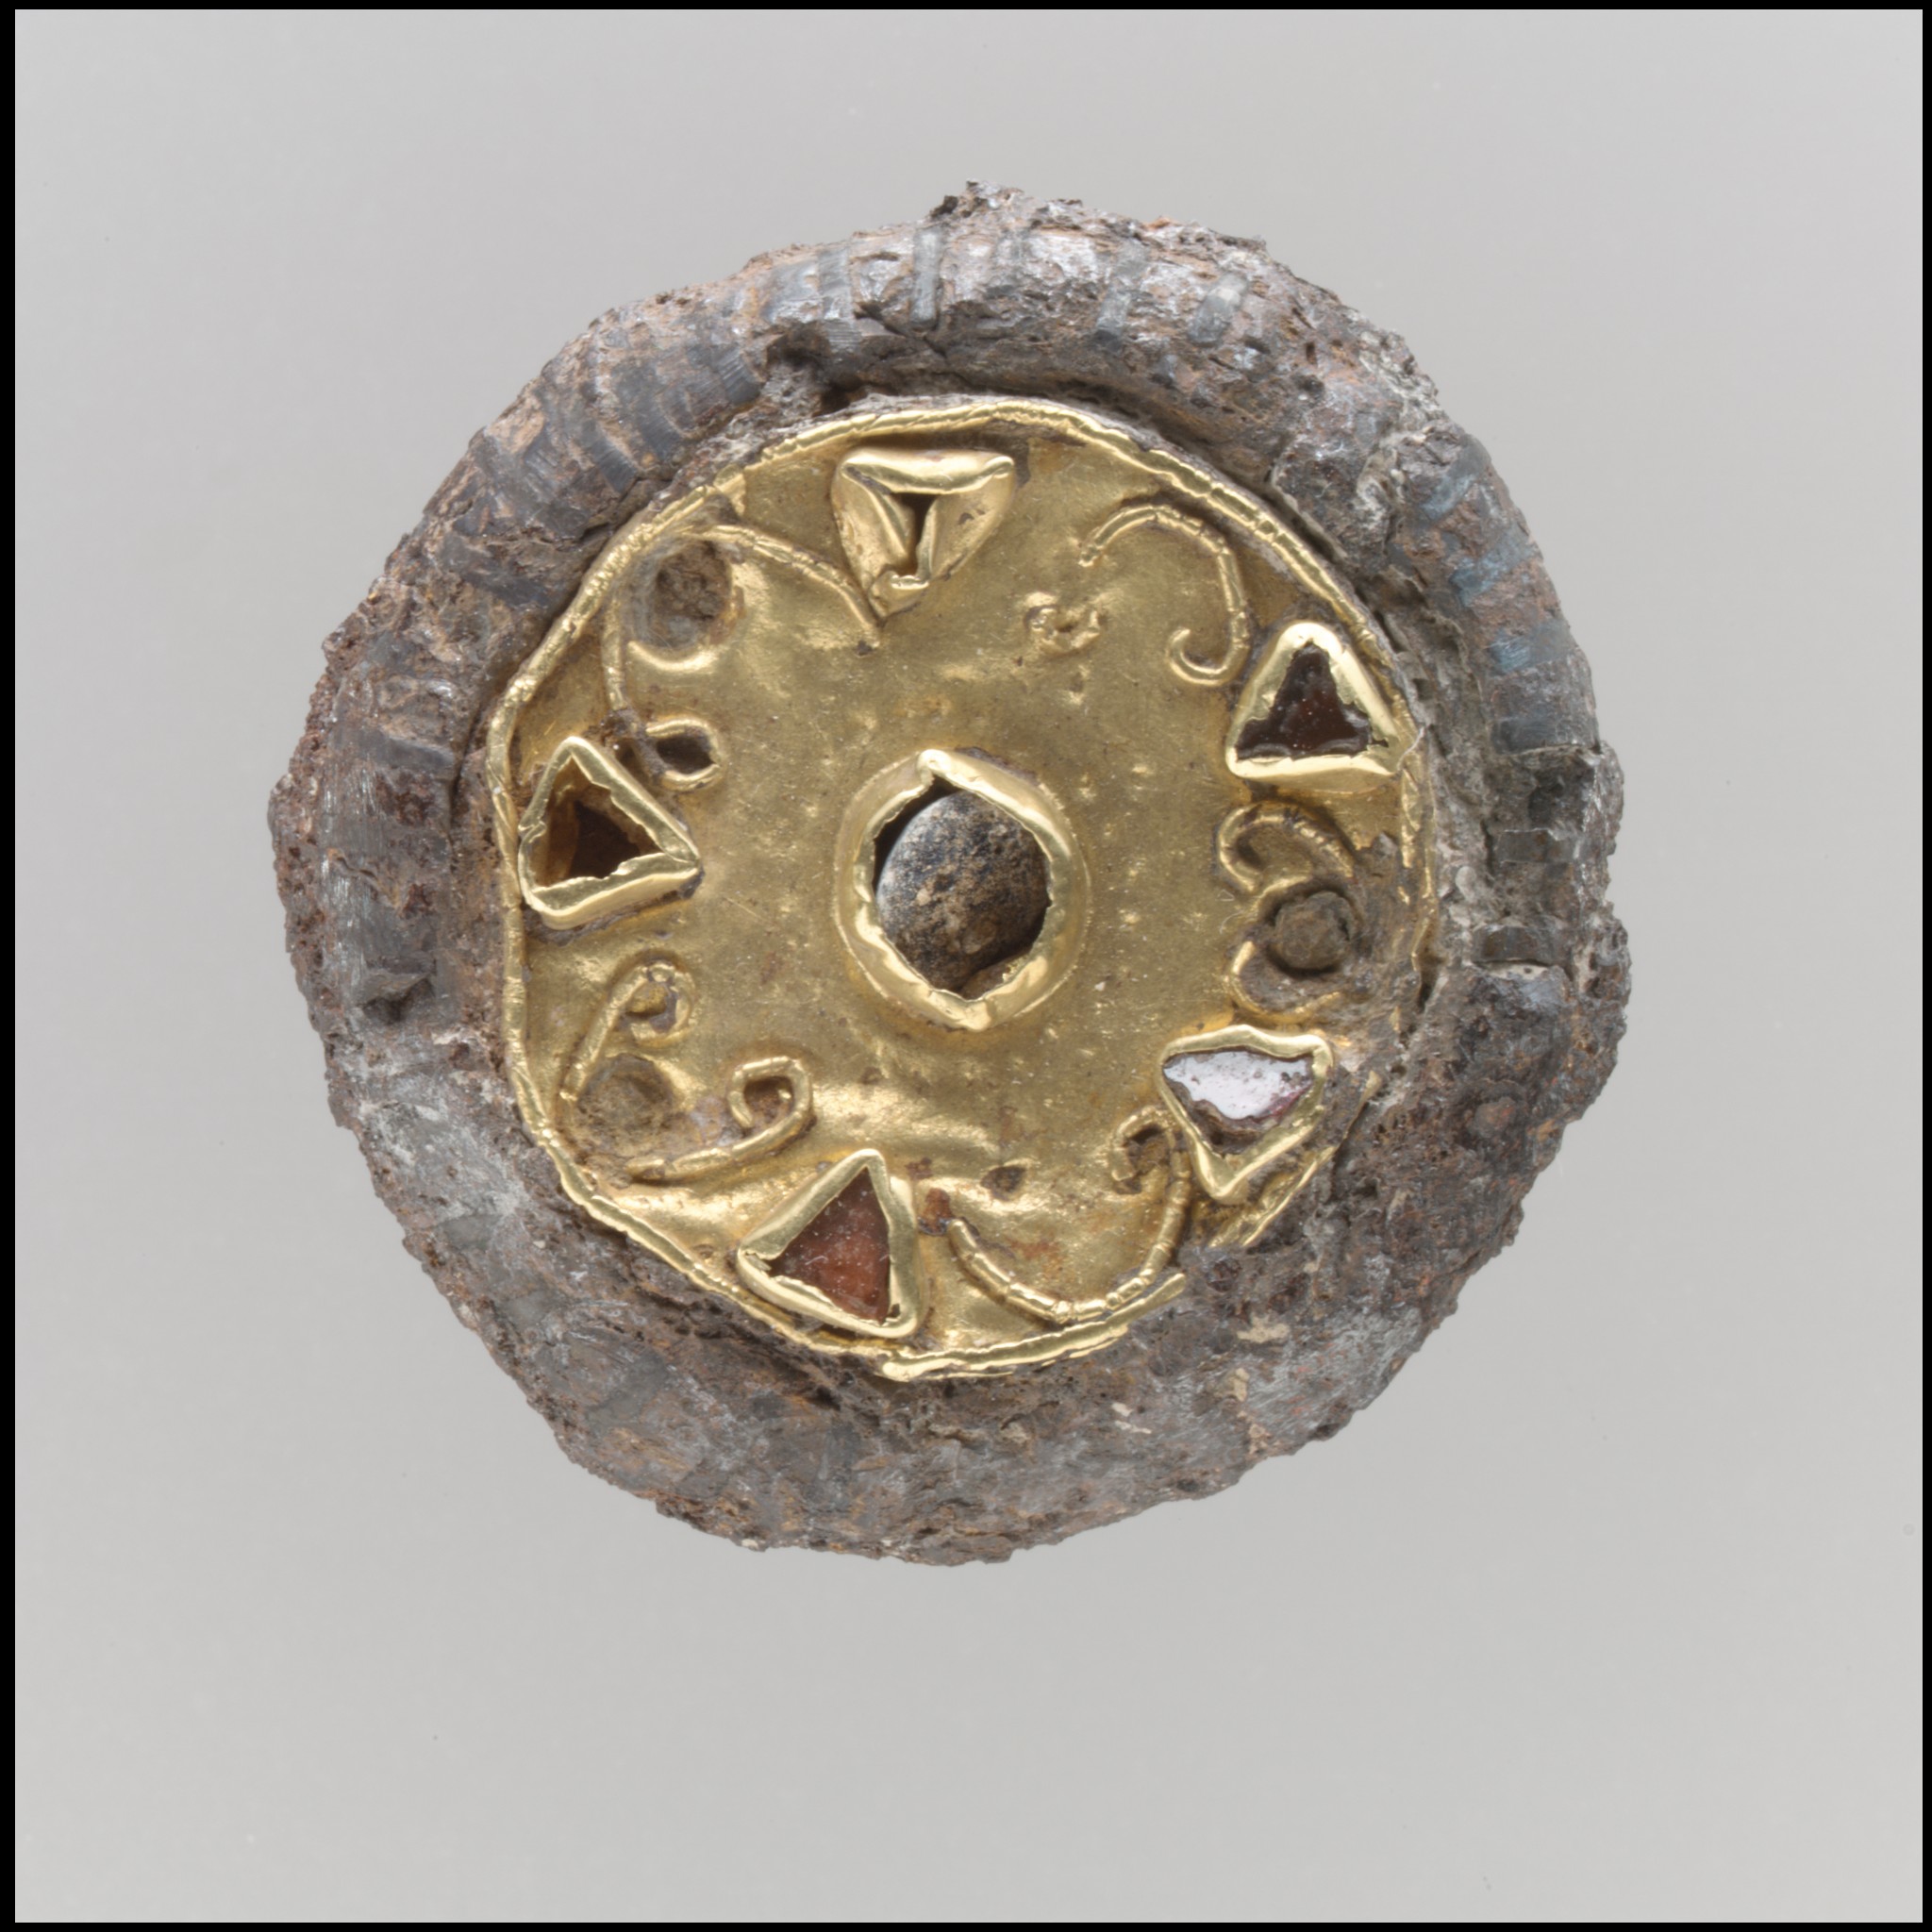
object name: brooch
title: Disk Brooch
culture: frankish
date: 550-650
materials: gold, iron, paste, metal